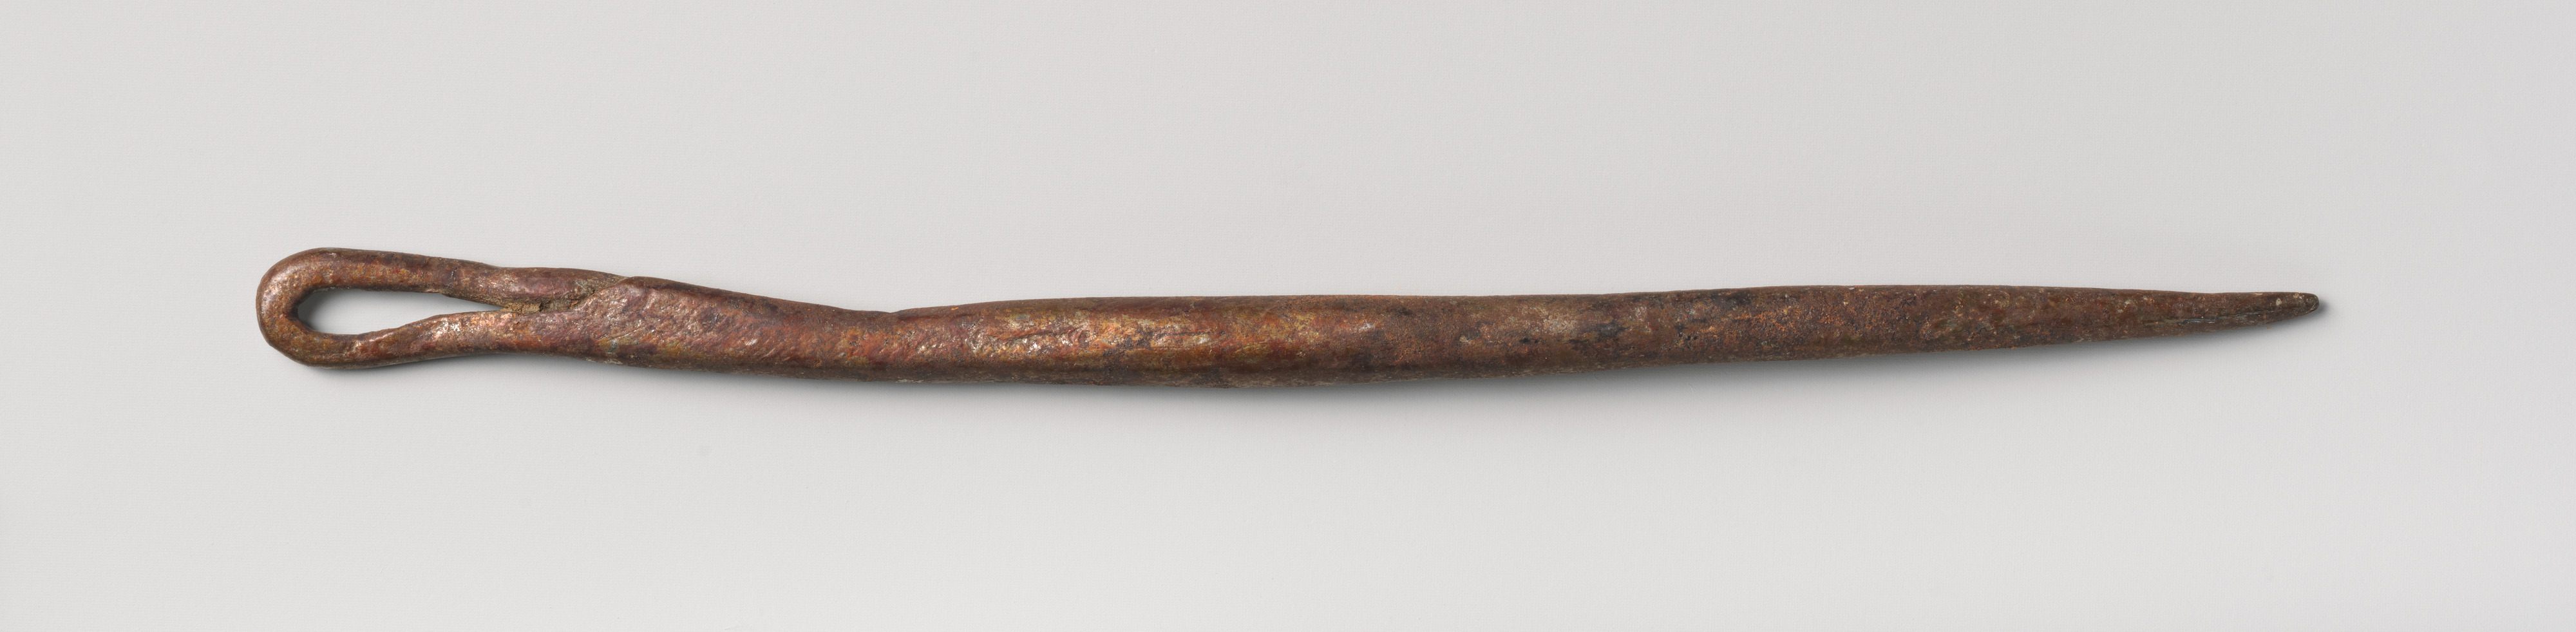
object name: needle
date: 101-200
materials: iron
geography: egypt